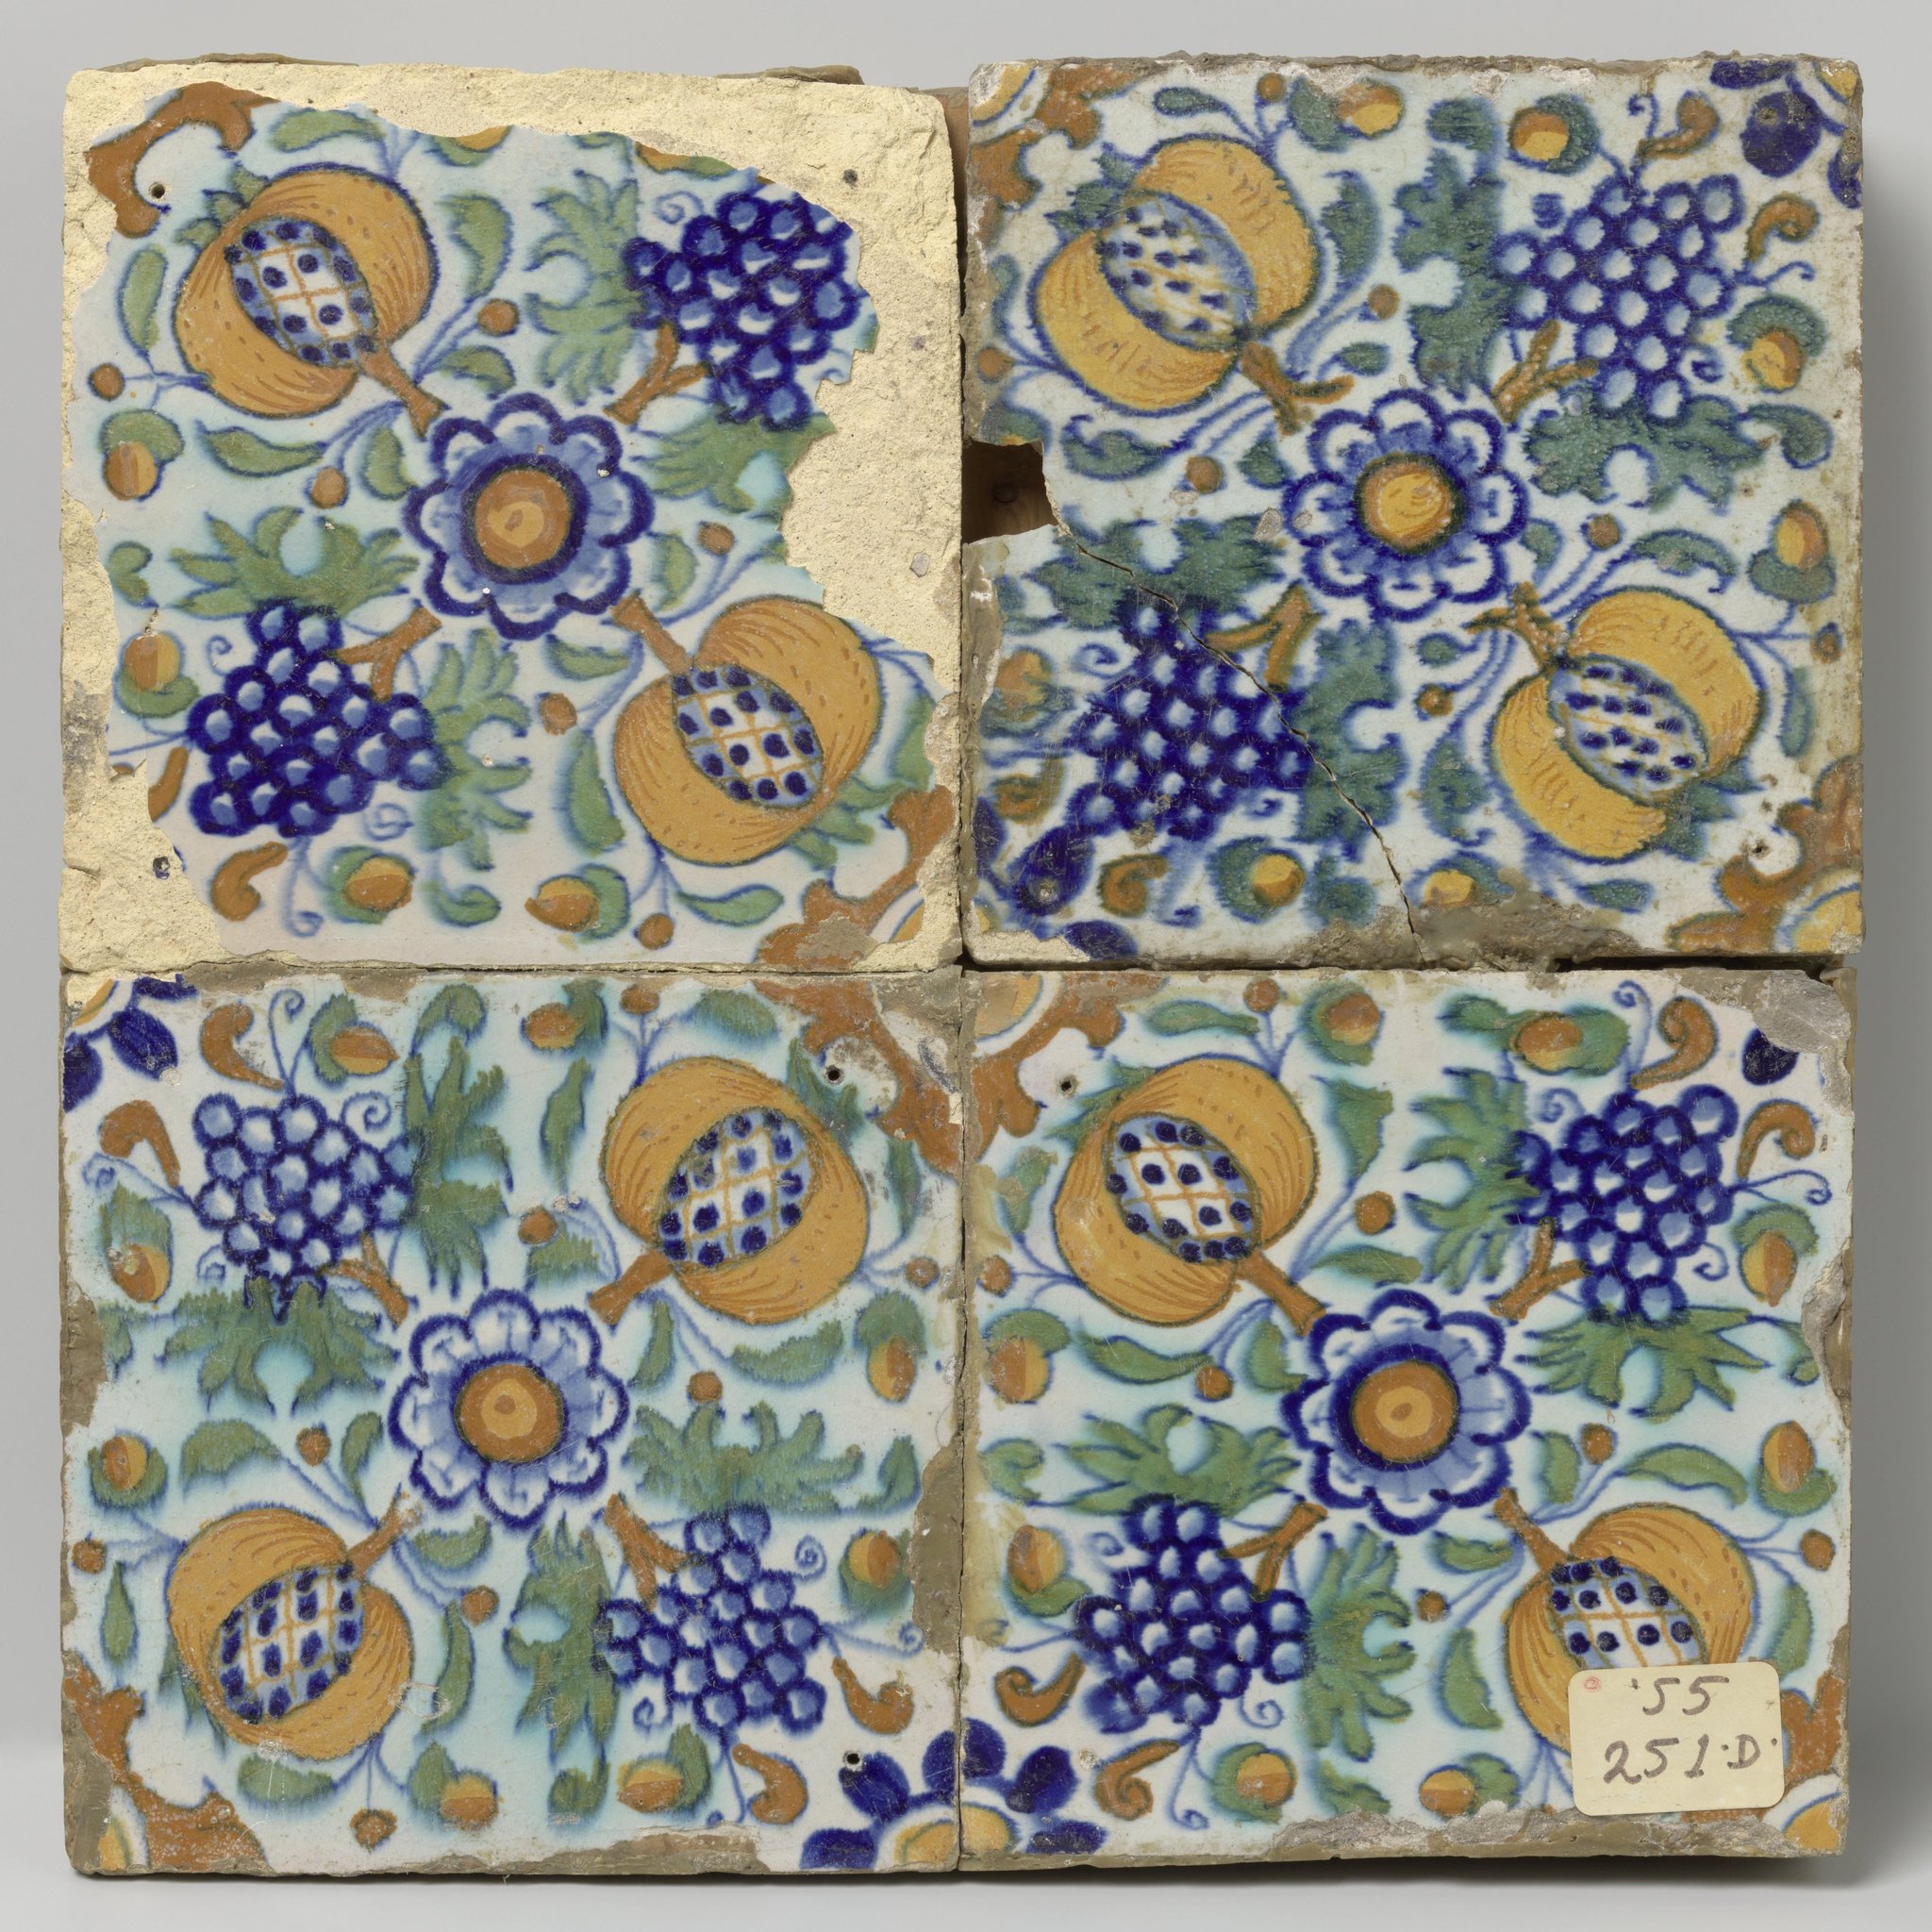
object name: tegelveld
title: Veld van vier tegels, met rozetten, druiventrossen en granaatappels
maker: Anonymous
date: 1600-1625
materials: earthenware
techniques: maiolica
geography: netherlands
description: Veld van vier tegels (2 x 2) elk met een veelkleurig (blauw, groen, geel en oranje) geschilderde voorstelling. In het midden een rozet omgeven door druiventrossen en granaatappels. In de hoeken, een kwart rozet.